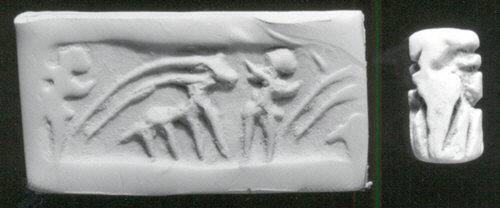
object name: cylinder seal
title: Cylinder seal with two-figure contest scene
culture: iranian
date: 1000-1 BCE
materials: faience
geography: iran